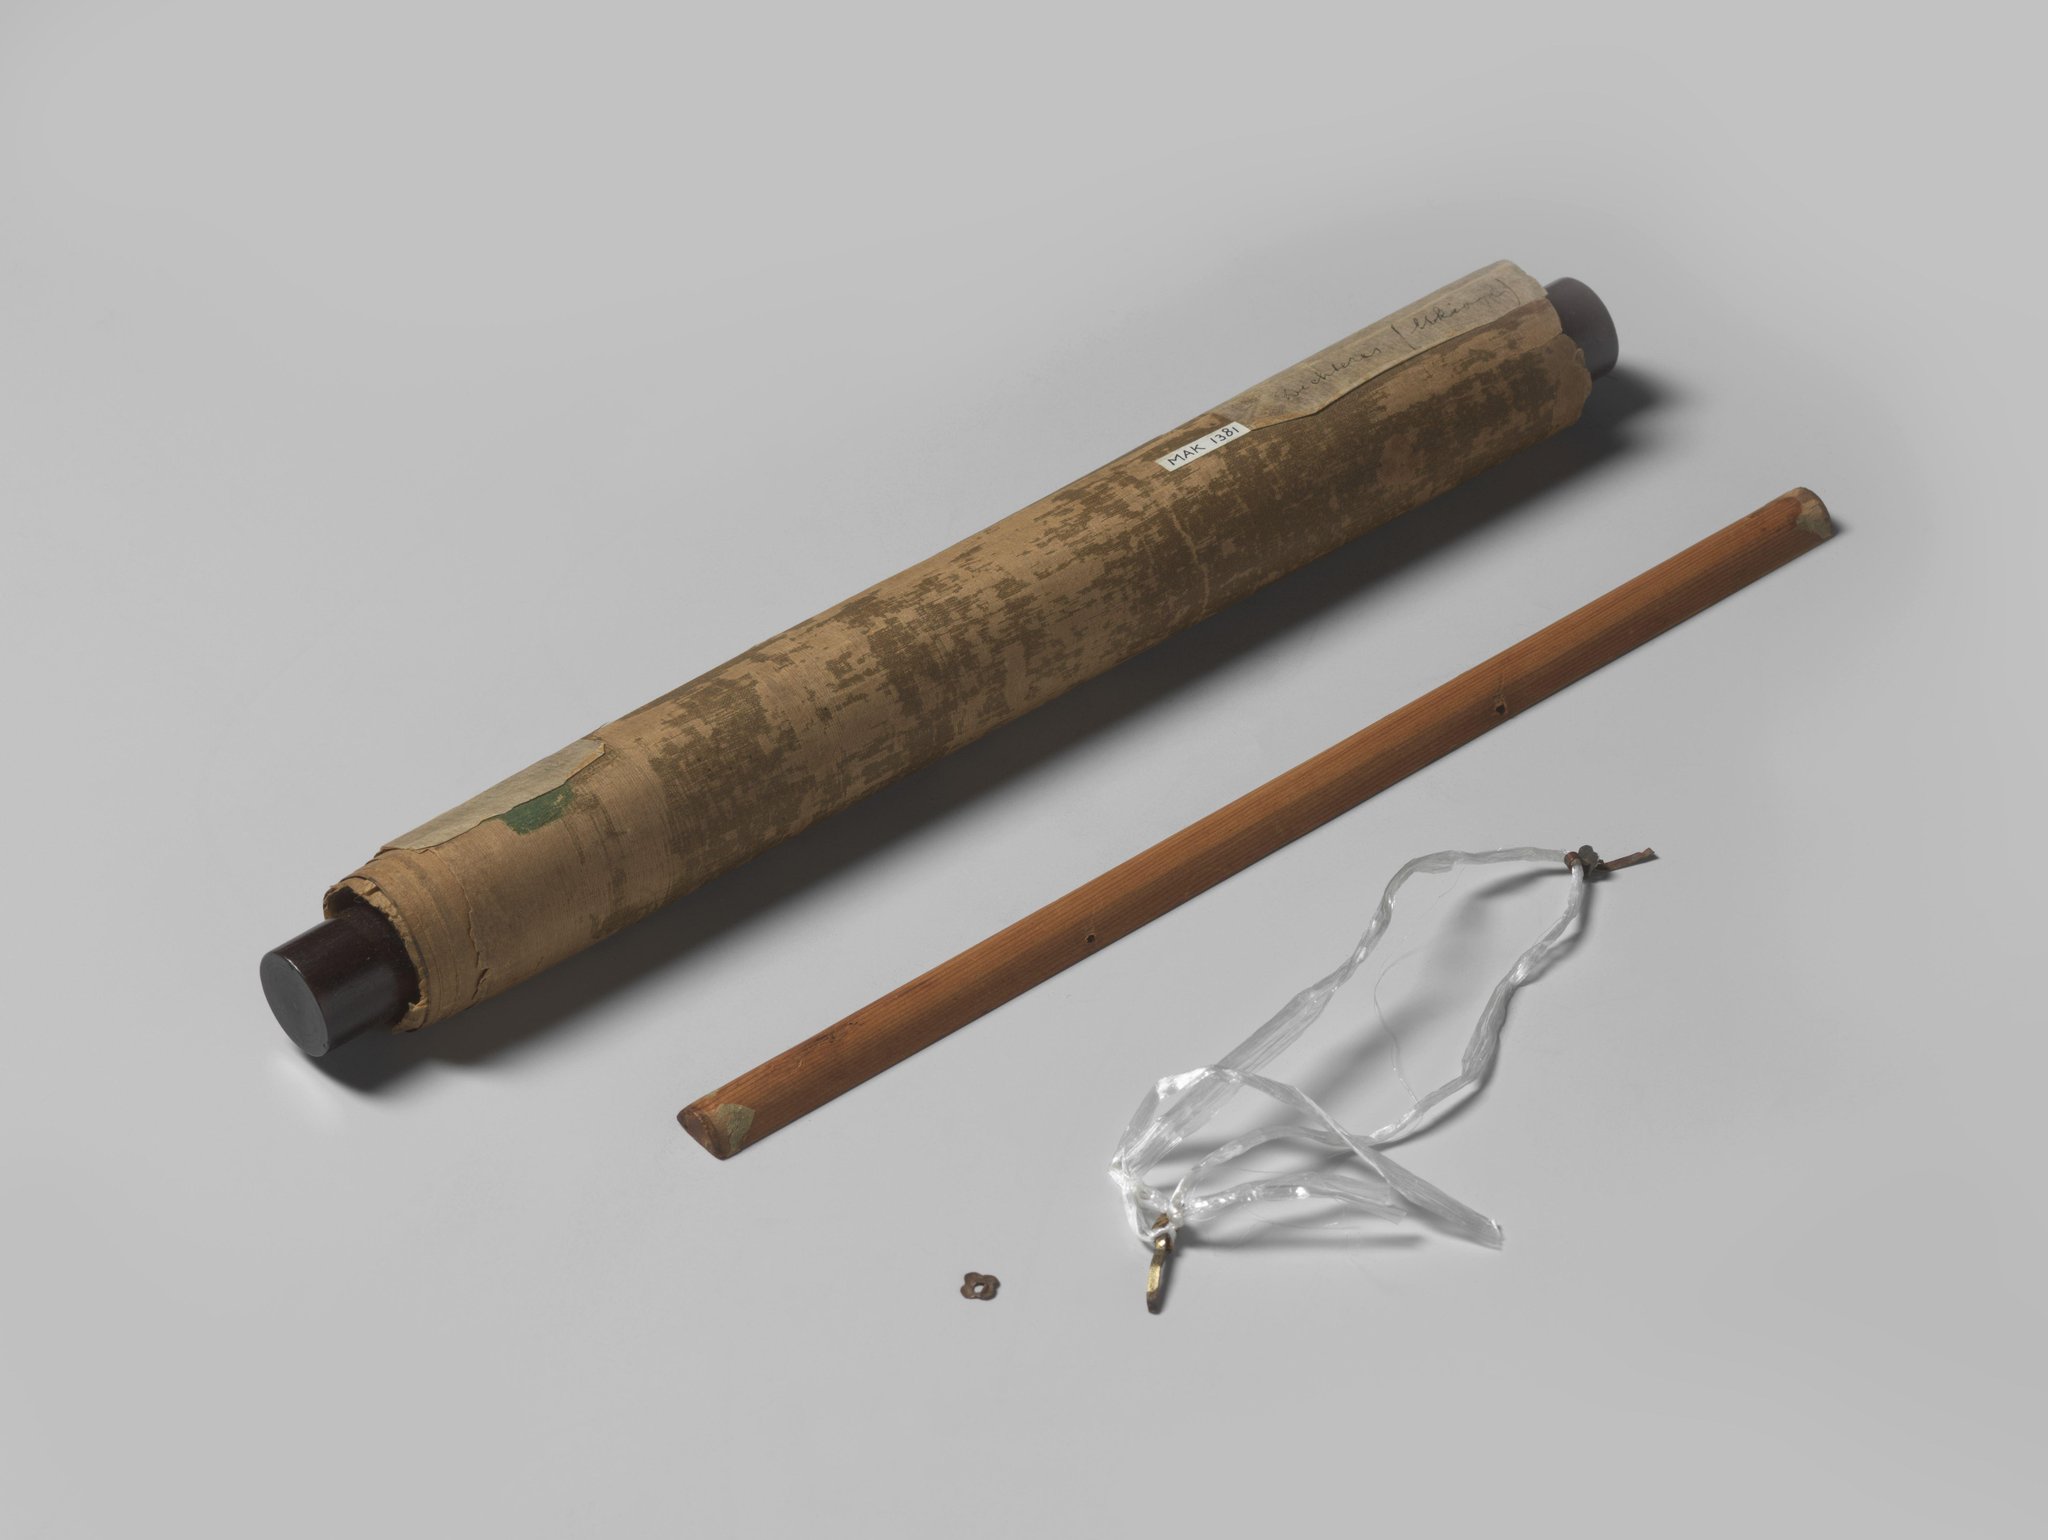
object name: passe partout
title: Passe-partout voor schildering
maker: tatsu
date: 1700-1800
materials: paper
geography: japan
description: Passe-partout voor schildering Staande vrouw leest een brief; in de lucht een vlucht ganzen en op de grond bladeren en een pruimebloesemtak.